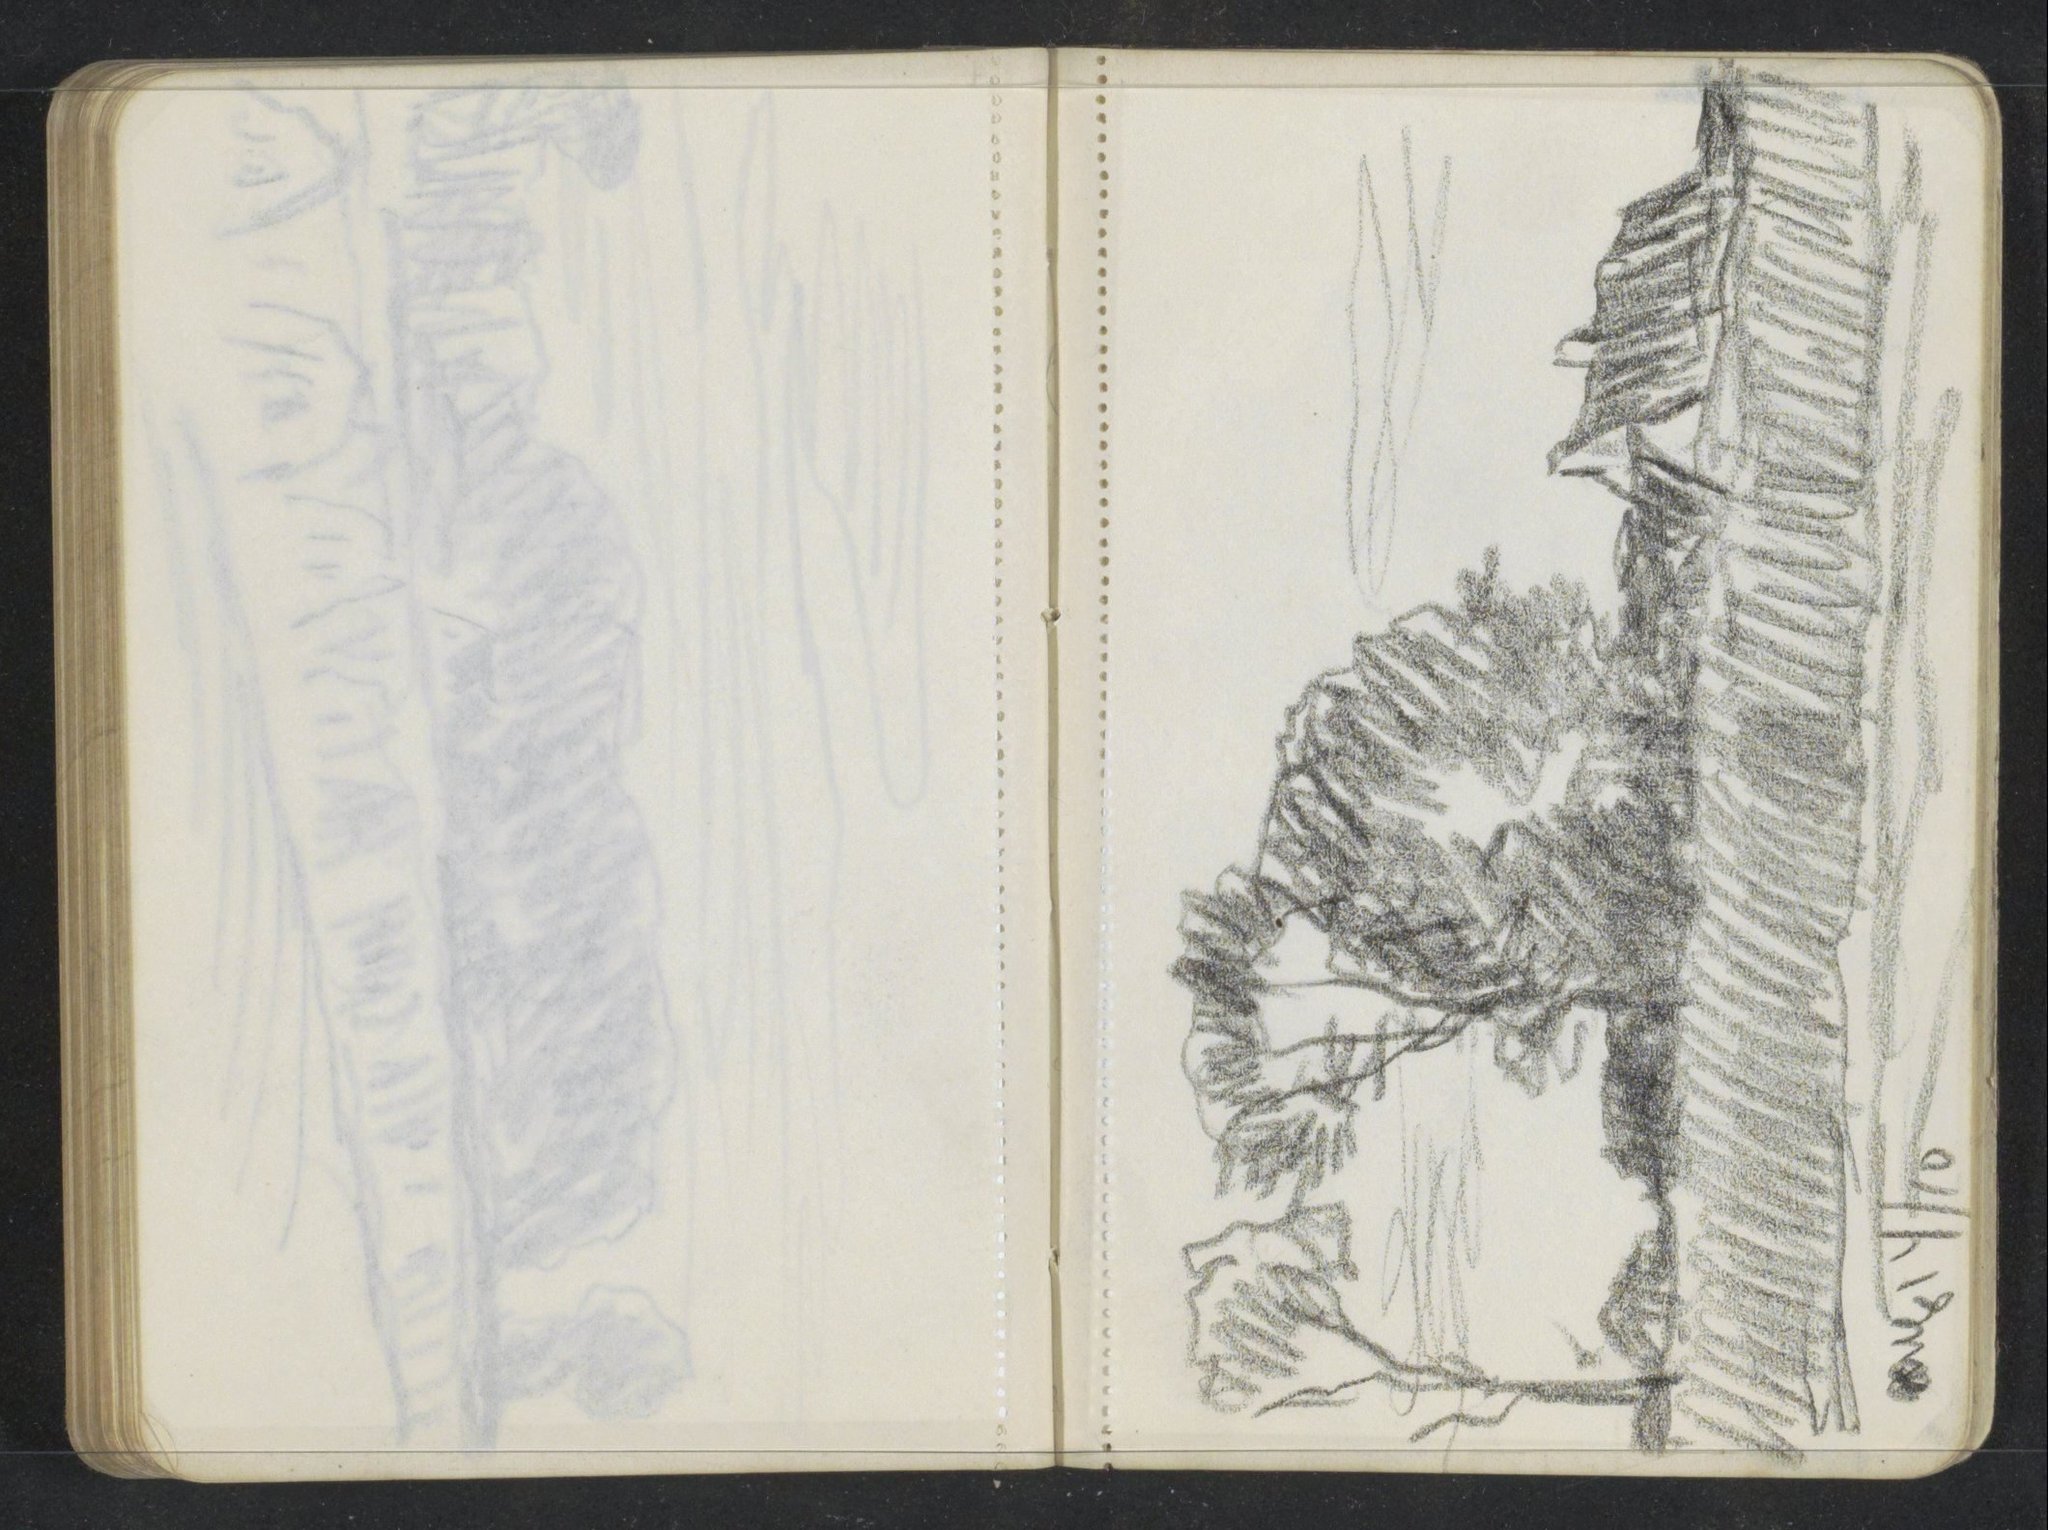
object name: sketchbook leaf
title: Boerderij in een landschap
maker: alexander shilling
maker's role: draughtsman, print maker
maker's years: 1859-1937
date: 1908-1910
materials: chalk, paper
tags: farm or solitary house in landscape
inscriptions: date: ‘aug 14/10’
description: Blad 83 recto uit een schetsboek met 91 bladen.